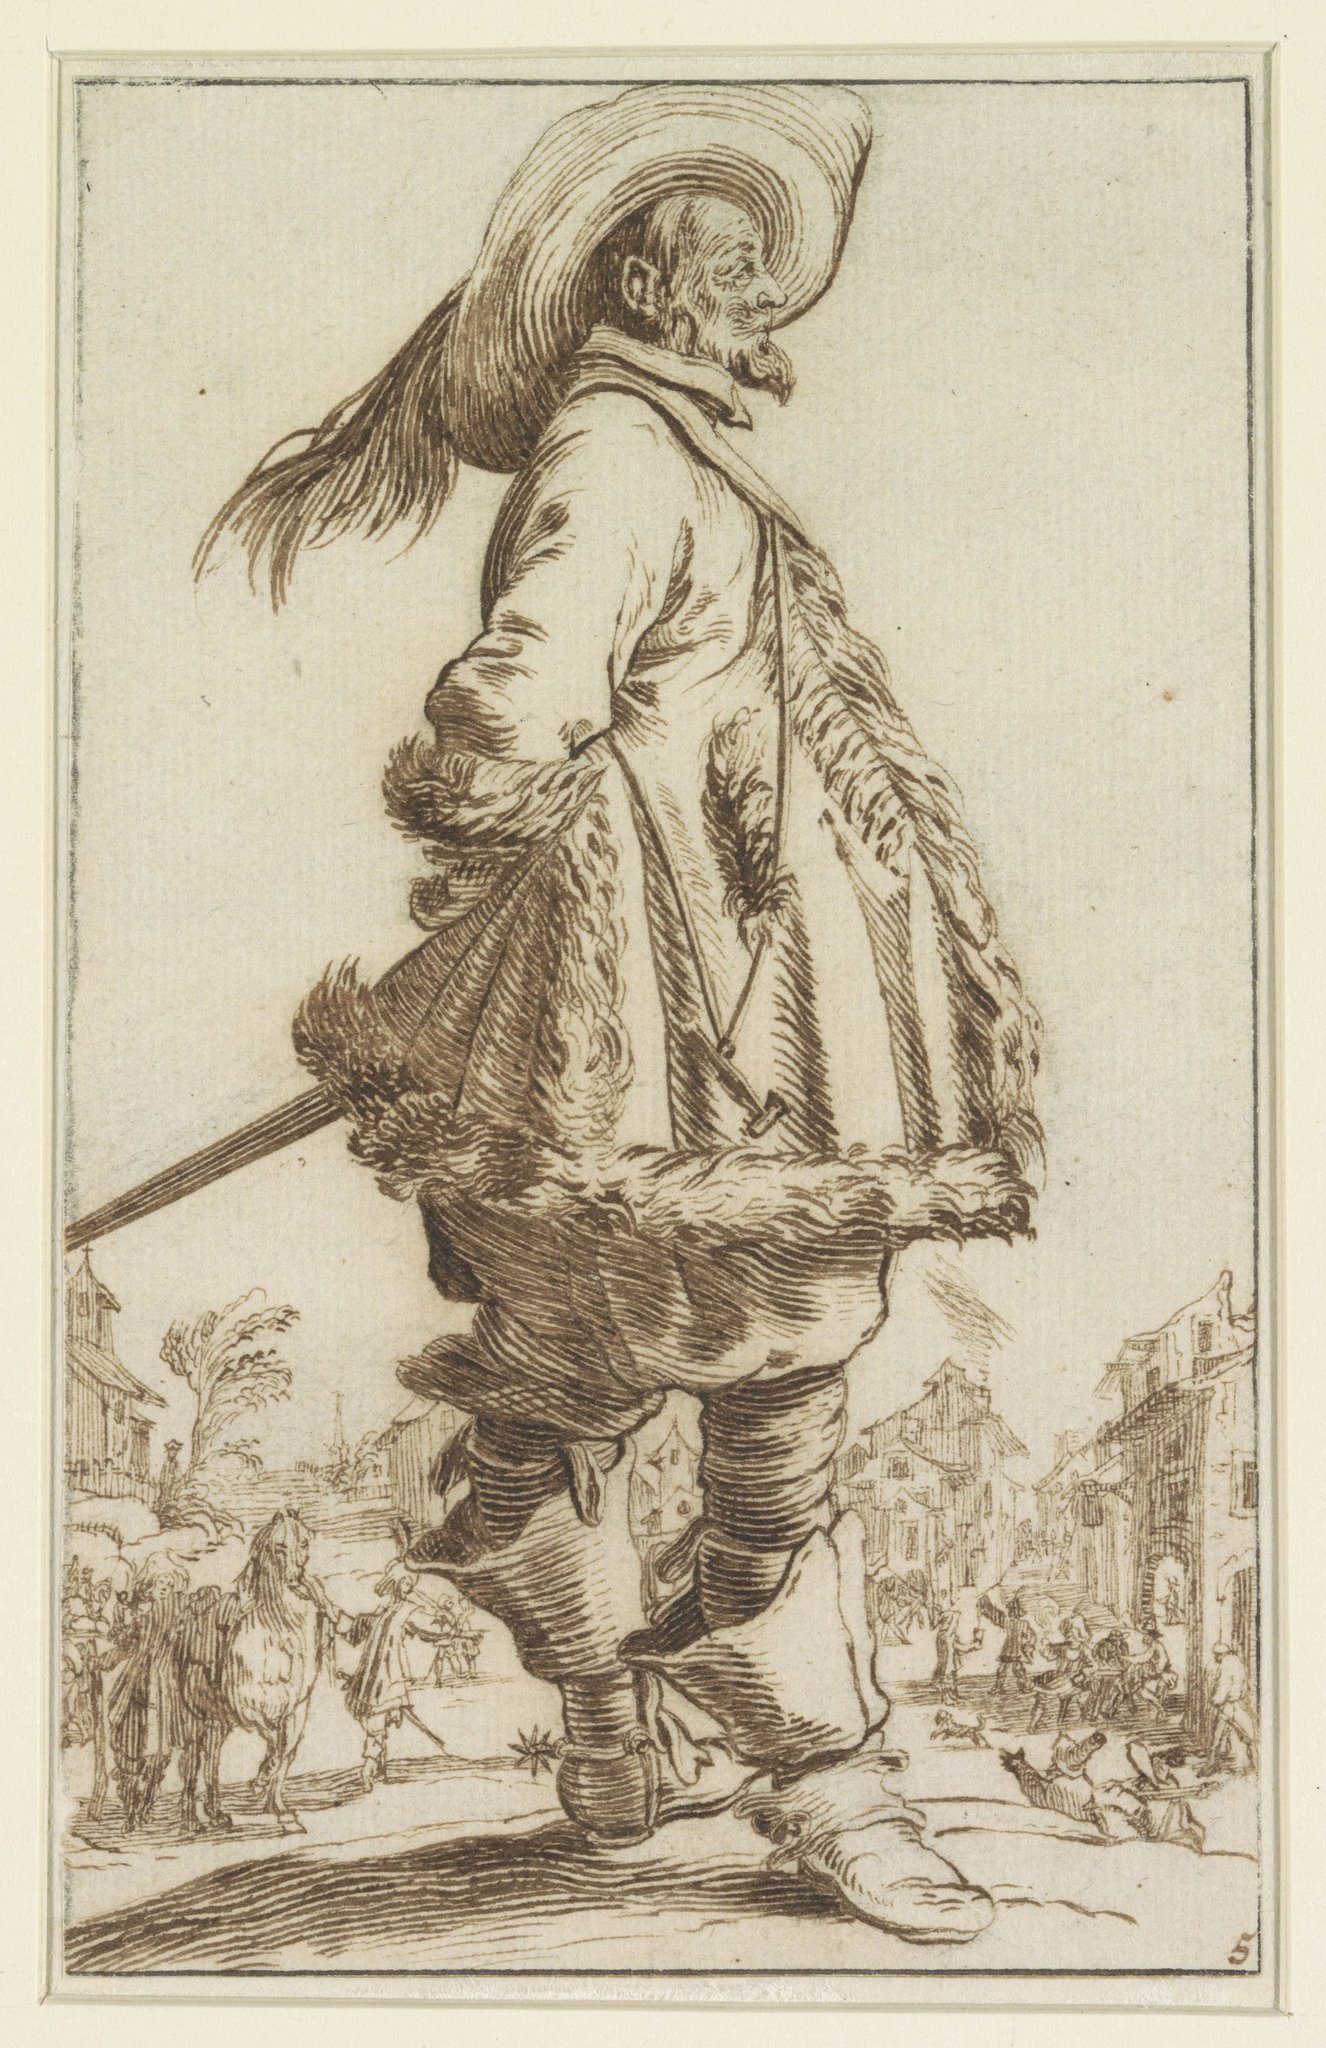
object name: drawing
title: Staande cavalier, naar rechts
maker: antoon overlaet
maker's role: draughtsman, print maker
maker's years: 1720-1774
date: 1730-1774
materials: ink, paper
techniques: pen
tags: standing figure, officer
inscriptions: collector's mark: Lugt 240